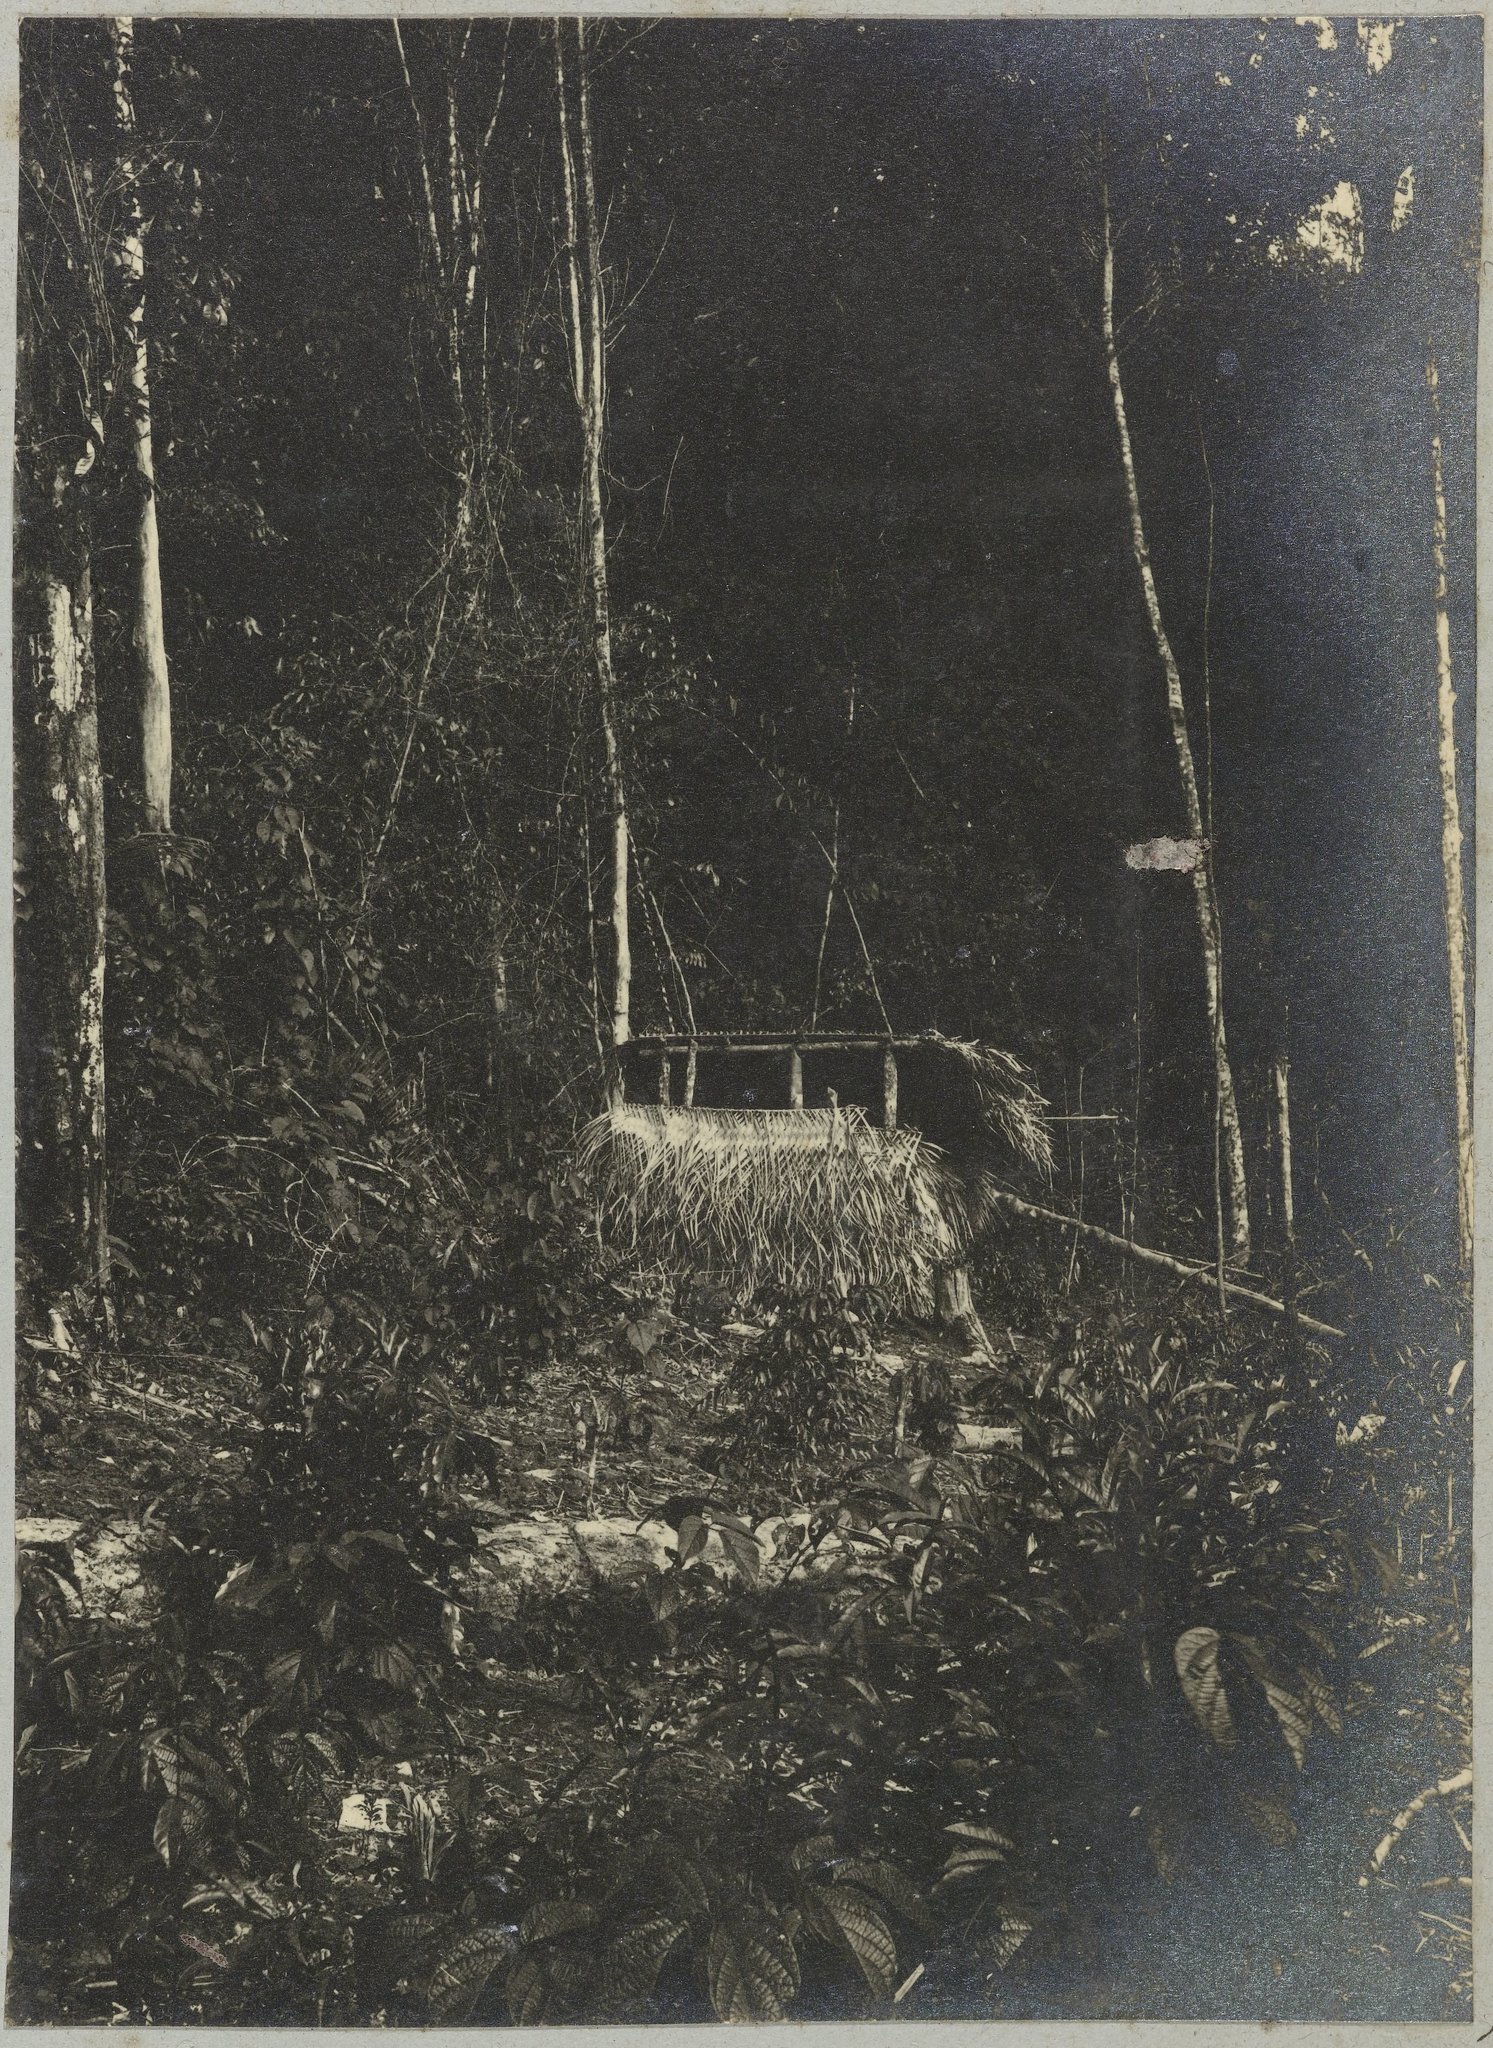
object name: photograph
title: W.C. op Mäabo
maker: hendrik doijer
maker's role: engineer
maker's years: 1863-1925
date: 1903-1910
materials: photographic support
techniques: gelatin silver print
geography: suriname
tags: suriname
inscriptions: inscription: ‘W.C. op Mäabo. / 1.’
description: Een WC of toilet gebouwd van takken en bladeren tussen bomen in het bos op de Maäbo Heuvel, waarschijnlijk tijdens de aanleg van de Lawaspoorweg (1903-1912). Onderdeel van het fotoalbum Souvenir de Voyage (deel 1), over het leven van de familie Doijer in en rond de plantage Ma Retraite in Suriname in de jaren 1903-1910.